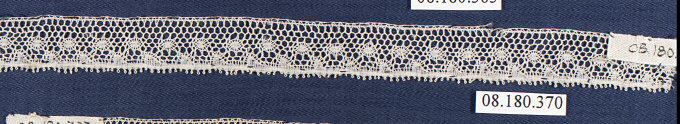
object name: piece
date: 1701-1800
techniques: lace